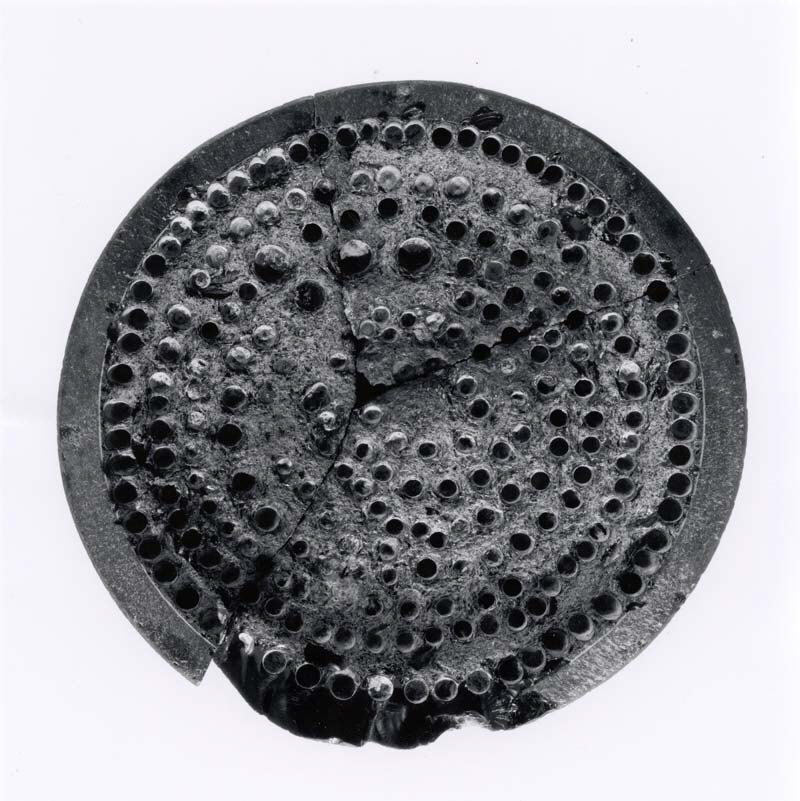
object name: bowl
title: Unfinished bowl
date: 3000-2001 BCE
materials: obsidian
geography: mesopotamia